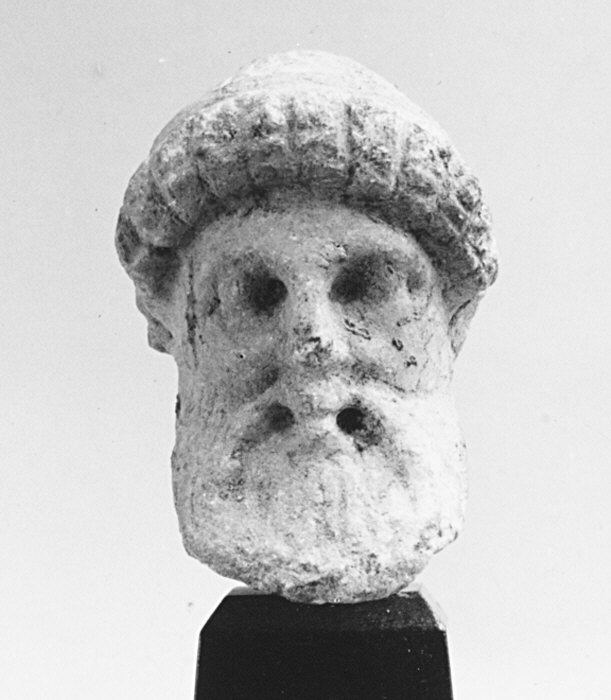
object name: head of hermes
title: Small marble herm of the Hermes by Alkamenes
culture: roman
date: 1-200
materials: marble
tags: heads,hermes